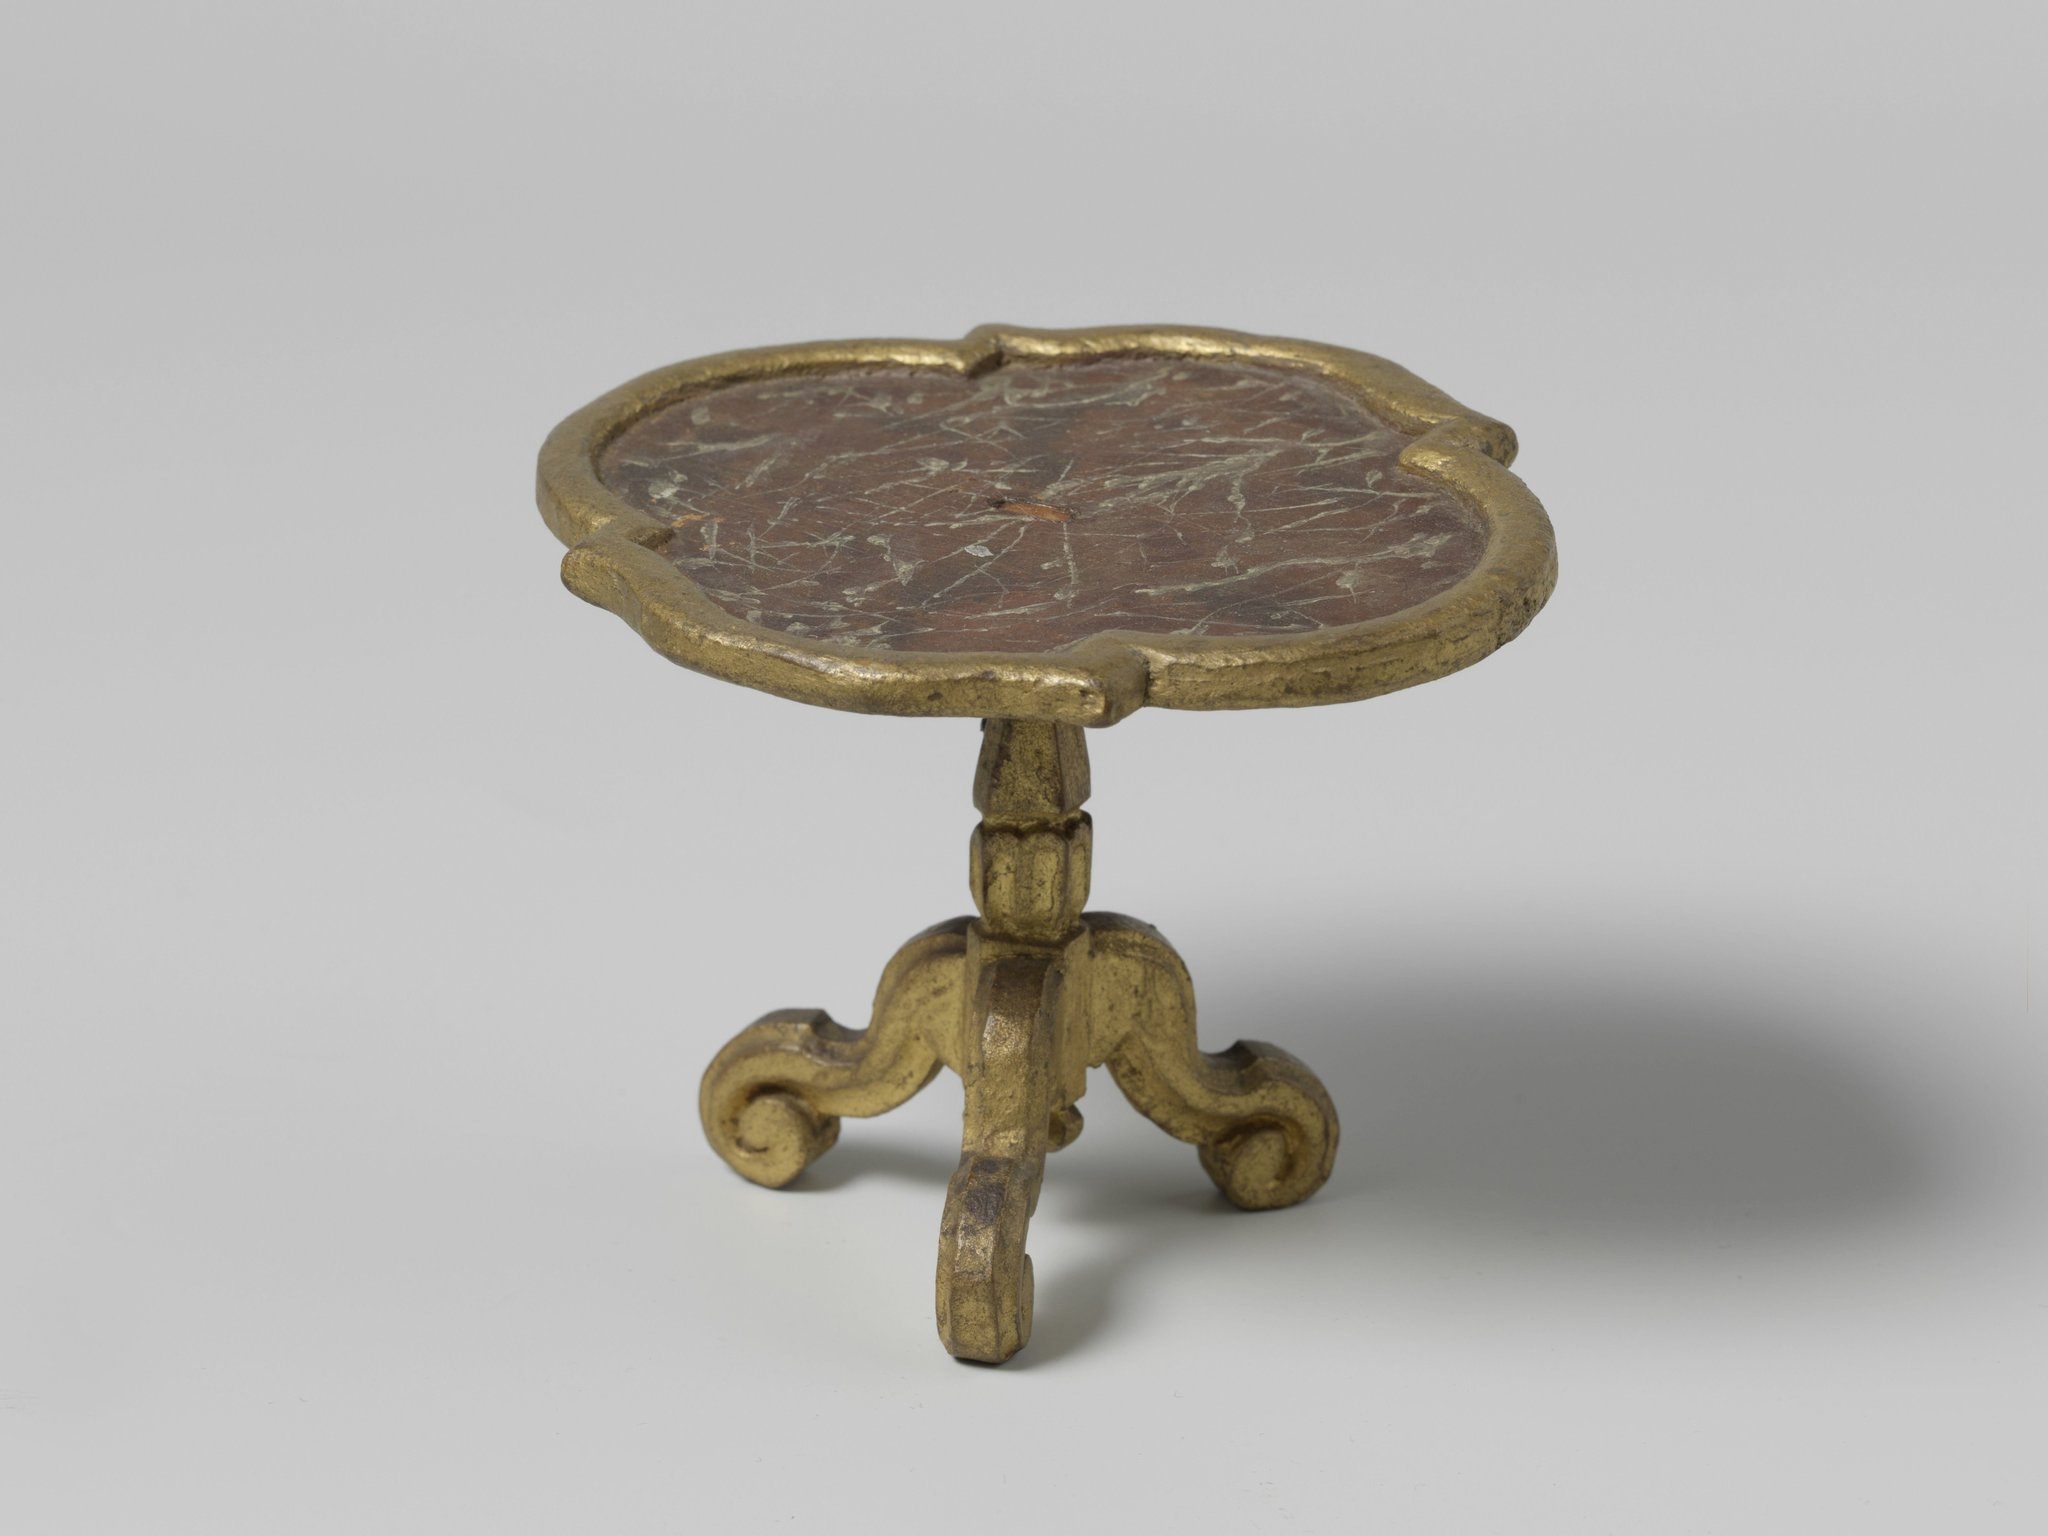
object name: miniature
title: Theetafel, met gemarmerd blad met ingesnoerde hoeken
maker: Anonymous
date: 1750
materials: without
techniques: gilding, marbling, painted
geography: amsterdam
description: Theetafel van without, het gemarmerde blad met ingesnoerde hoeken heeft een vergulde, opstaande rand. Het scharnierende blad rust op een stam op drie voluutvormige poten.